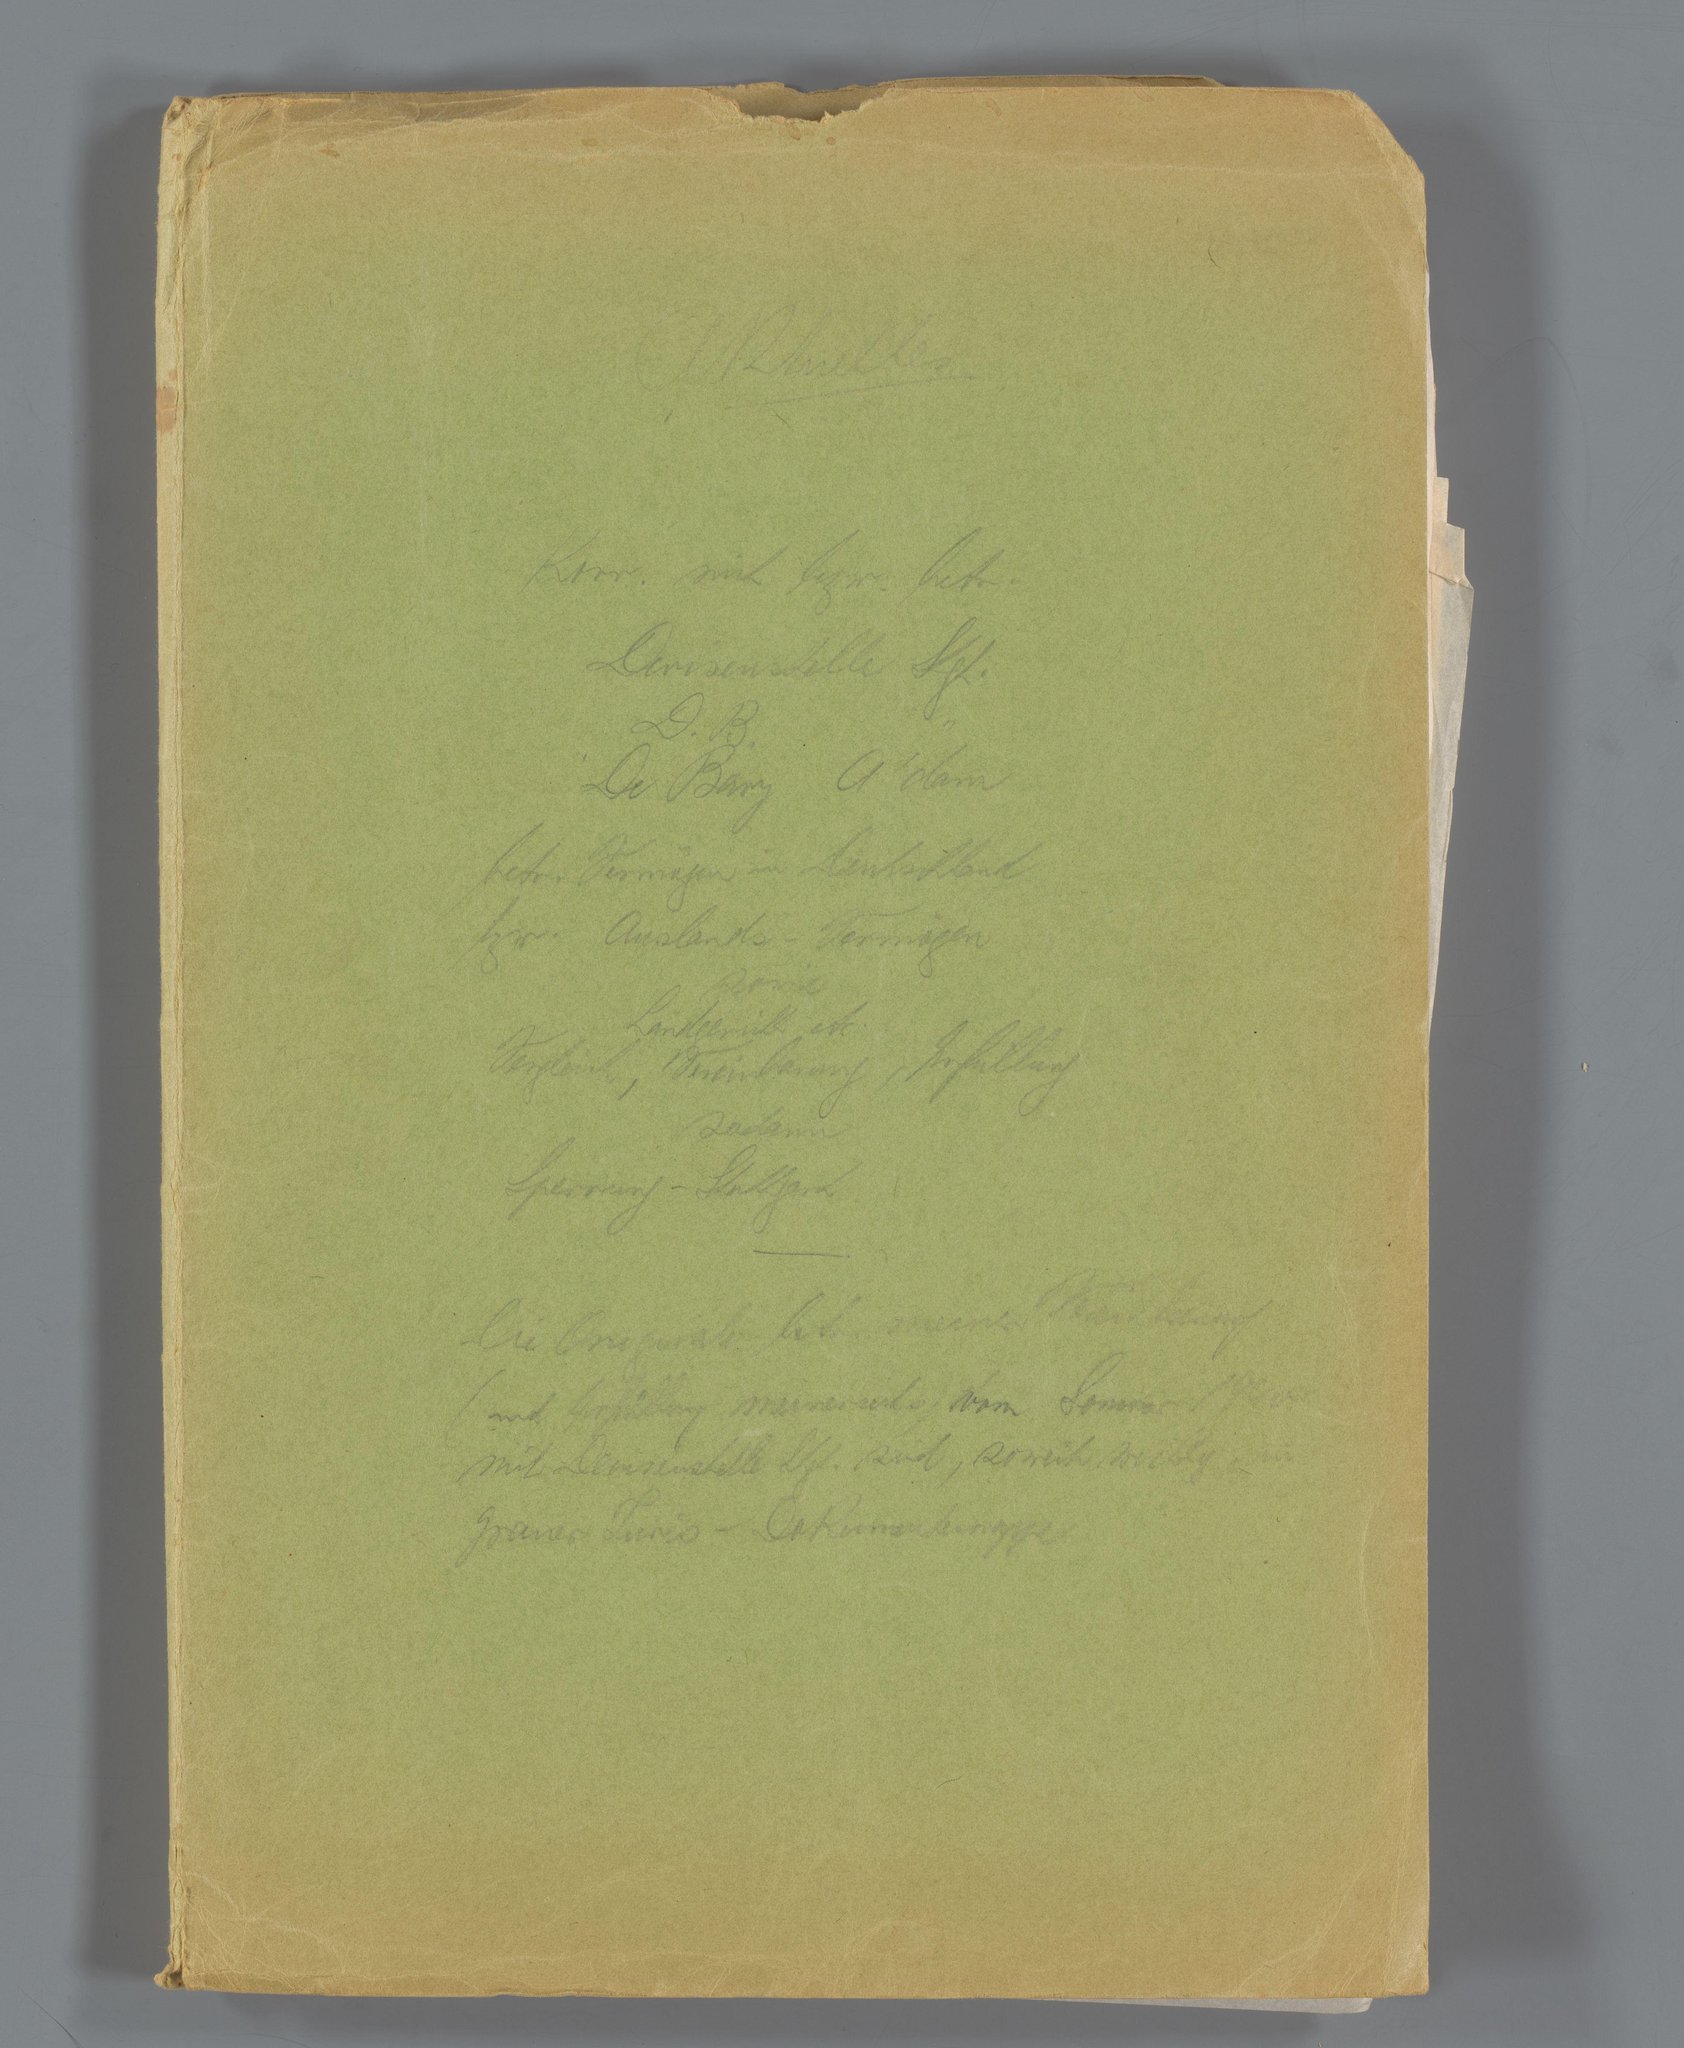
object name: correspondence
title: Correspondentie Eugen Wachenheimer over teruggave van zijn vermogen in Duitse banken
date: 1937-1941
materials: paper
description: Dit object is onderdeel van de nalatenschap van Isabel Elon-Wachenheimer (1928-2010). Tot haar overlijden behoorde het samen met de andere objecten uit de nalatenschap tot haar privédomein van Isabel Wachenheimer. In die particuliere context zijn deze objecten tezamen en individueel aandenkens - aan de jeugd, ouders en familie van Isabel Wachenheimer vóór en tijdens de Shoah en aan haar leven na de Tweede Wereldoorlog. Isabel Wachenheimer, die van juni 1943 tot mei 1945 gevangen zat in Kamp Westerbork, Theresienstadt, Auschwitz, Lenzing a/d Oberdonau (een buitenkamp van Mauthausen), overleefde de Shoah. Haar ouders – Eugène Wachenheimer en Else Wachenheimer-Moos - werden op 14 oktober 1944 in Auschwitz-Birkenau vermoord.